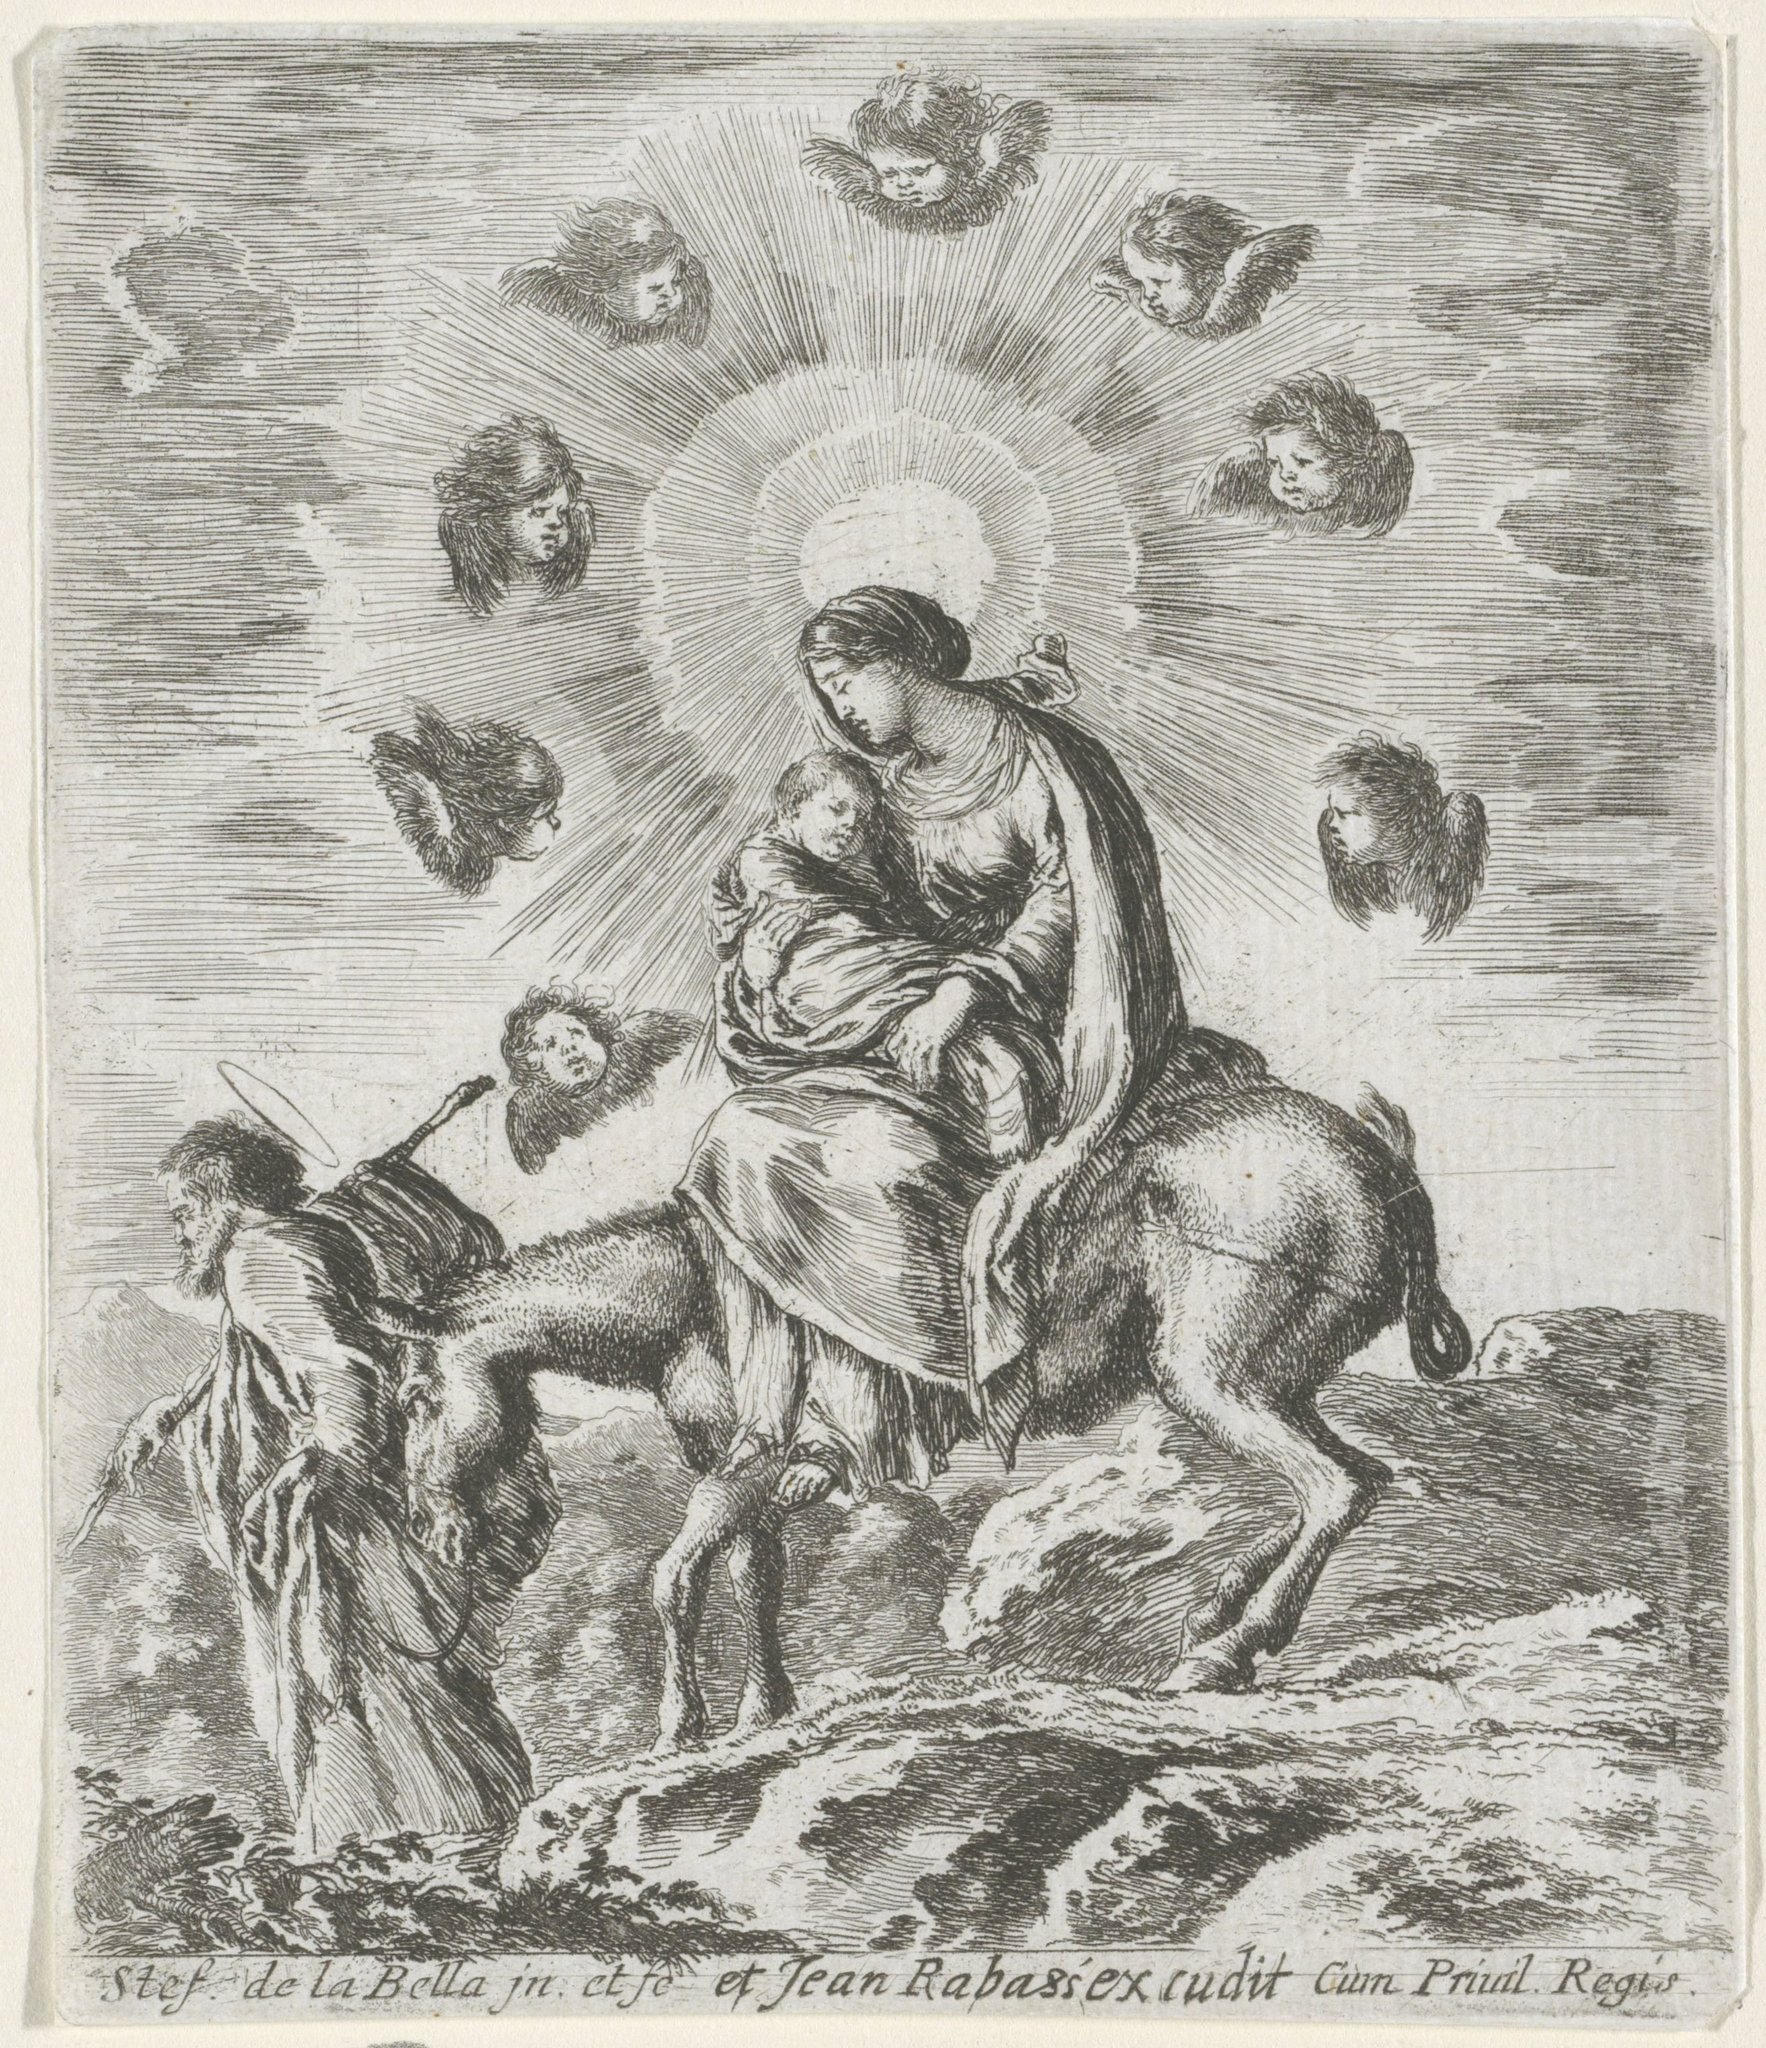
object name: print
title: Vlucht naar Egypte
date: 1620-1664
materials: paper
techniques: etching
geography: italy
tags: the flight into egypt: mary, joseph, the child (and sometimes others) on their way; mary usually riding on an ass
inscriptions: collector's mark: Lugt 240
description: Maria zit samen met het Christuskind op een ezel. Om haar heen zweven acht cherubijnen. Jozef trekt de ezel voort.